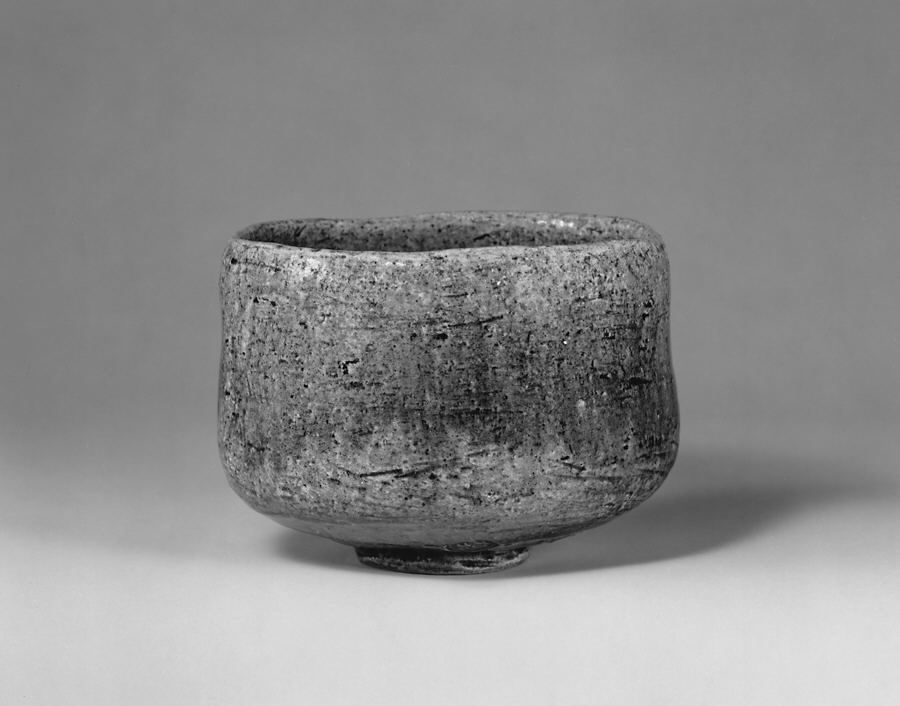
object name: teabowl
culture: japanese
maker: mitsutada ohi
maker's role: artist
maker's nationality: japanese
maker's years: 1835-1896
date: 1801-1900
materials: pottery